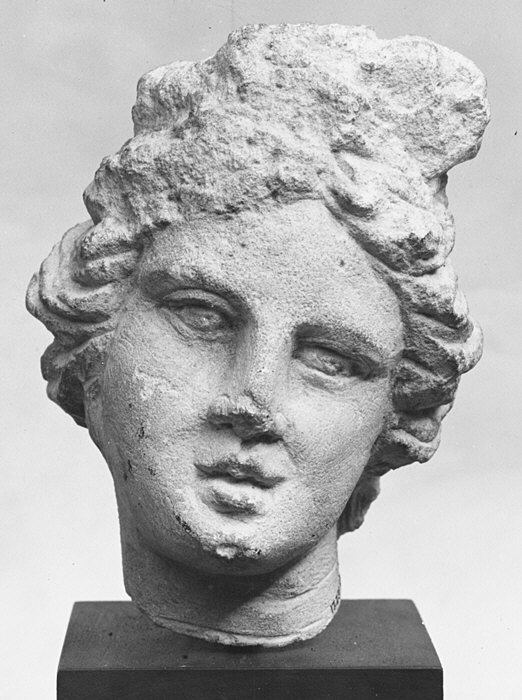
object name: head of a girl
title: Limestone head of a girl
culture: greek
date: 300-201 BCE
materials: limestone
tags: heads,girls